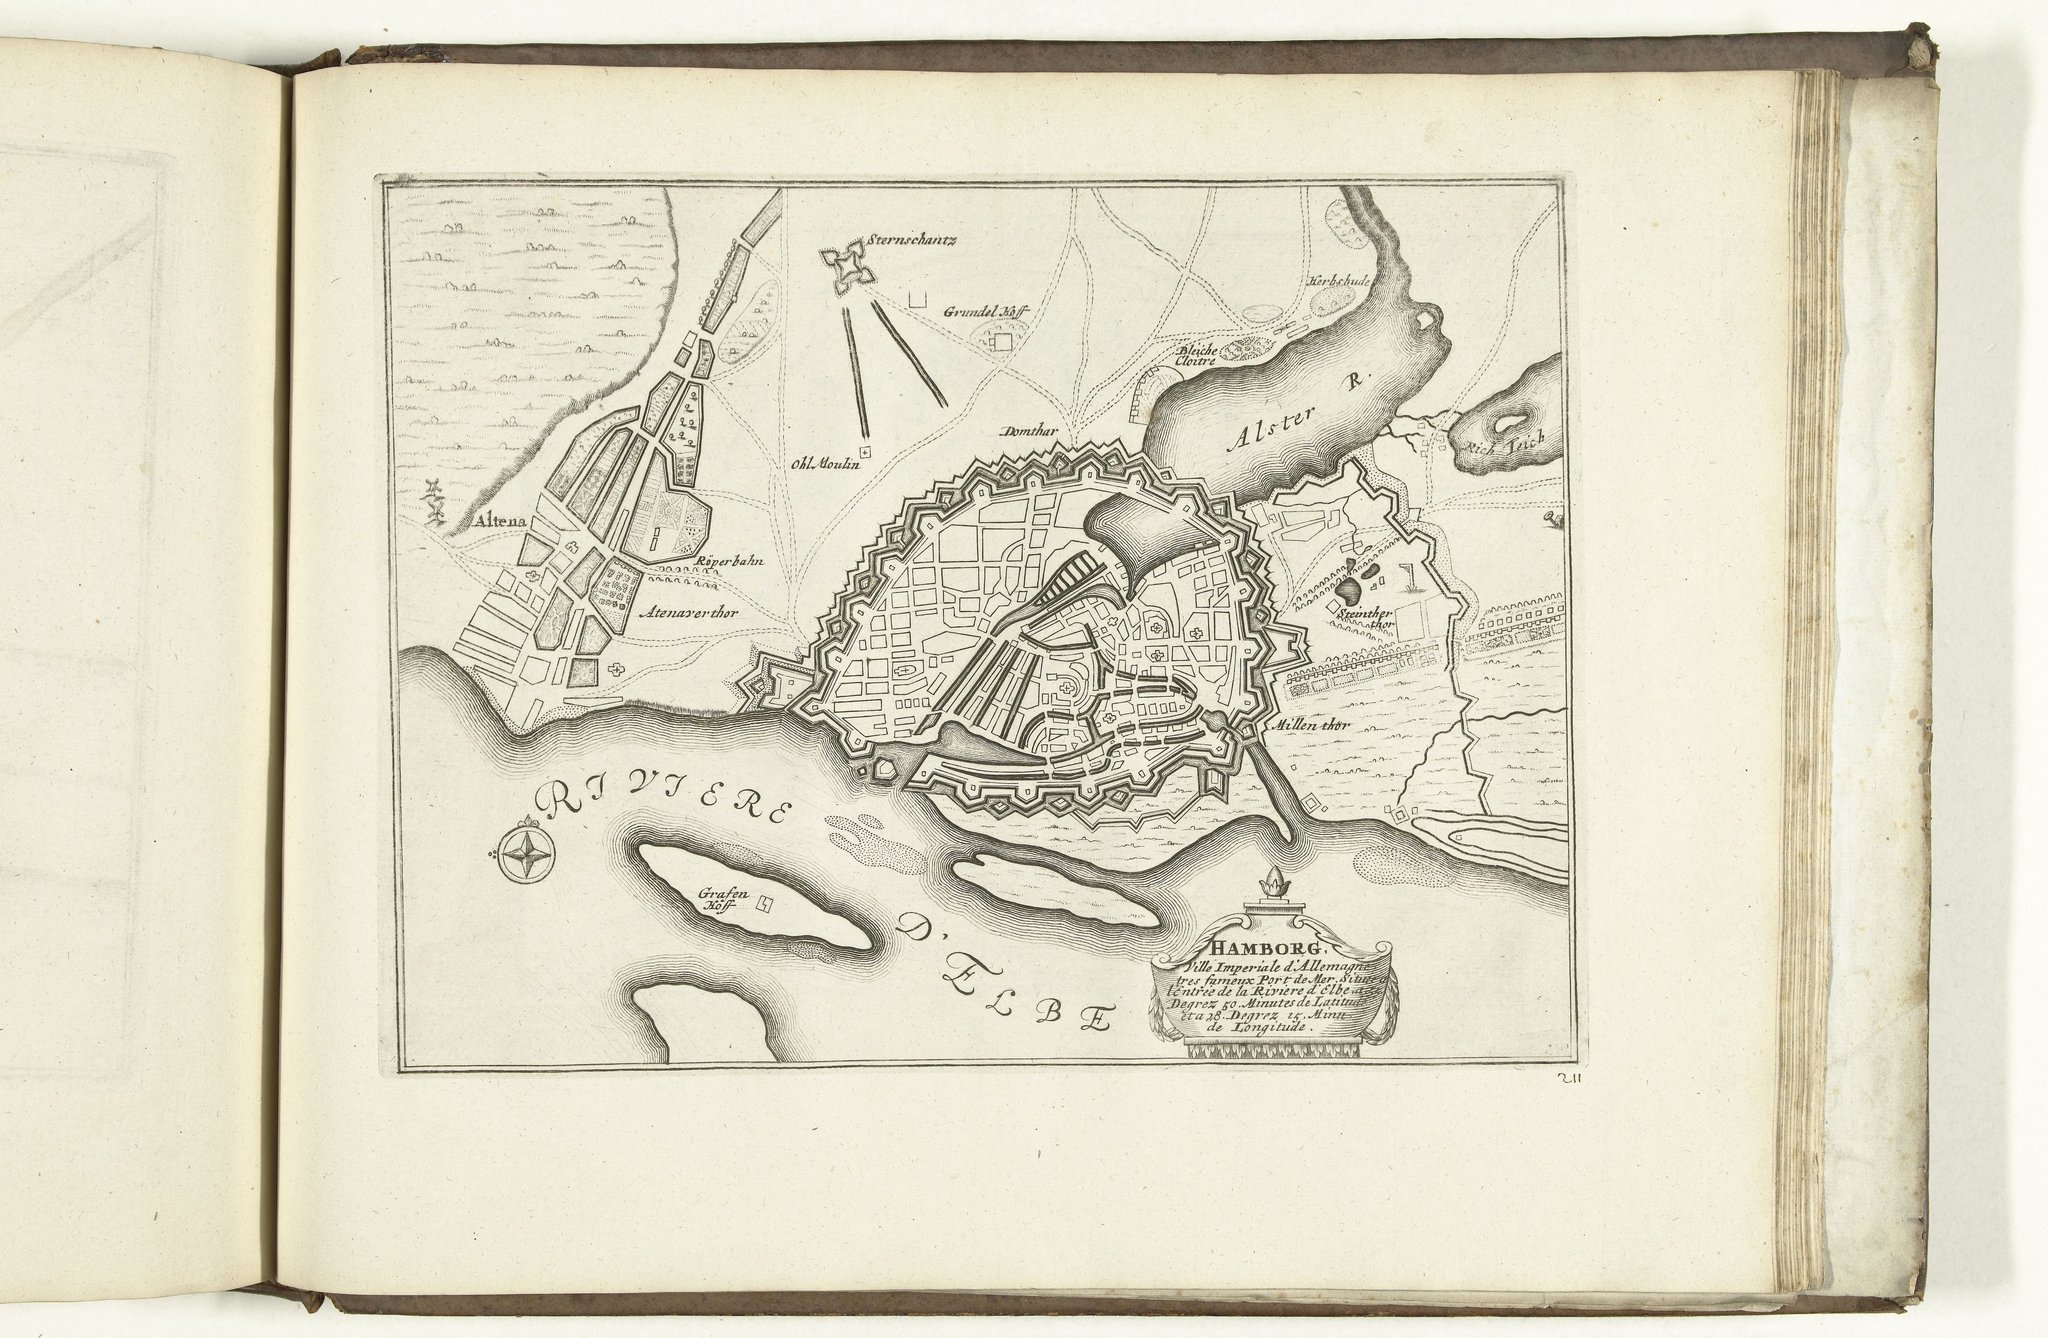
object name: map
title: Hamborg, Ville Imperiale d'Allemagne (...)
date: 1726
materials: paper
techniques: engraving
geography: leiden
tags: fortress, maps of cities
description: Plattegrond van de versterkingen om de Duitse havenstad Hamburg. Plaat nr. 211 in deel IX van het prentwerk: Les Forces de l'Europe, Asie, Afrique et Amerique ... Comme aussi les Cartes des Côtes de France et d'Espagne uit 1726, dit eerste deel met 238 met de hand genummerde platen van vermaarde sterke steden en vestingen in het kader van de Spaanse Successieoorlog 1701-1713. Voor het merendeel zijn deze platen gekopieerd naar de anonieme Franse platen van vermaarde sterke steden en vestingen: in Les forces de l'Europe en in: Le theatre de la guerre, dans les Pays-Bas, beide oorspronkelijk uitgegeven door Nicolas de Fer te Parijs (1693-1697) in het kader van de Negenjarige Oorlog. Titel en opschriften in het Frans. Rechtsonder sporen van het weggepolijste nummer: 139.